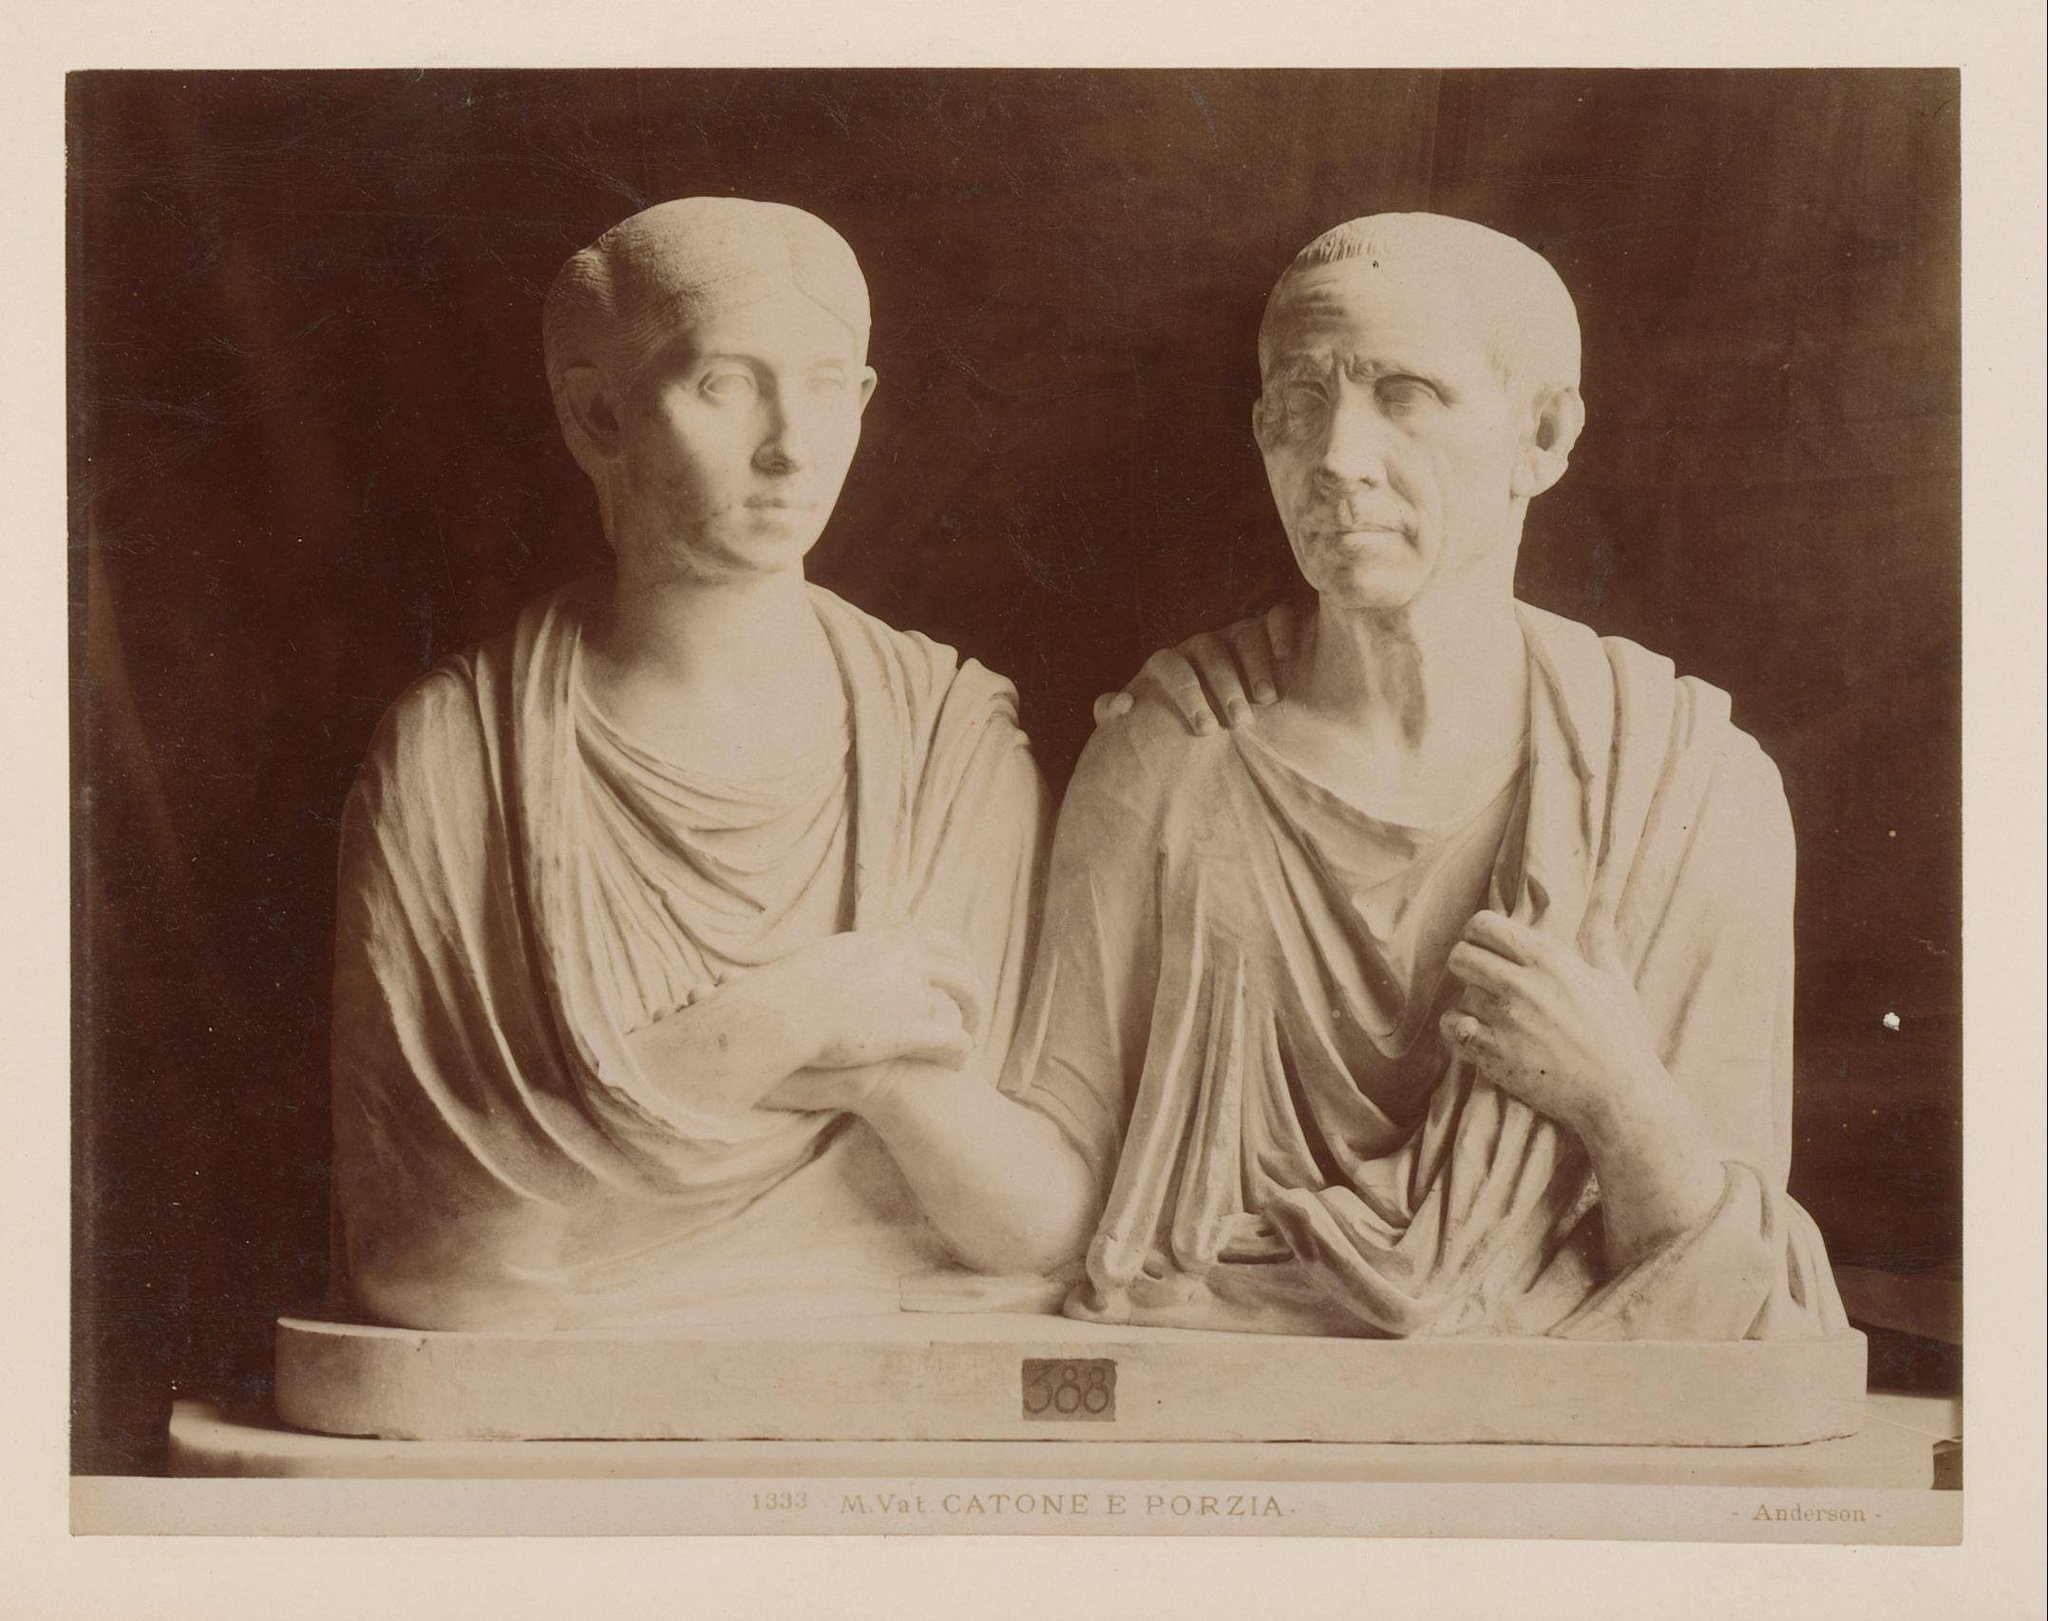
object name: album leaf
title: Catone e Porzia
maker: james anderson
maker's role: fotograaf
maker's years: 1813-1877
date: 1857-1875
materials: paper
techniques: albumen print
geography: vatican museums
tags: father and daughter(s) (family group), piece of sculpture, reproduction of a piece of sculpture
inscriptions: inscription: ‘1333 M. Vat. CATONE E PORZIA - Anderson -’